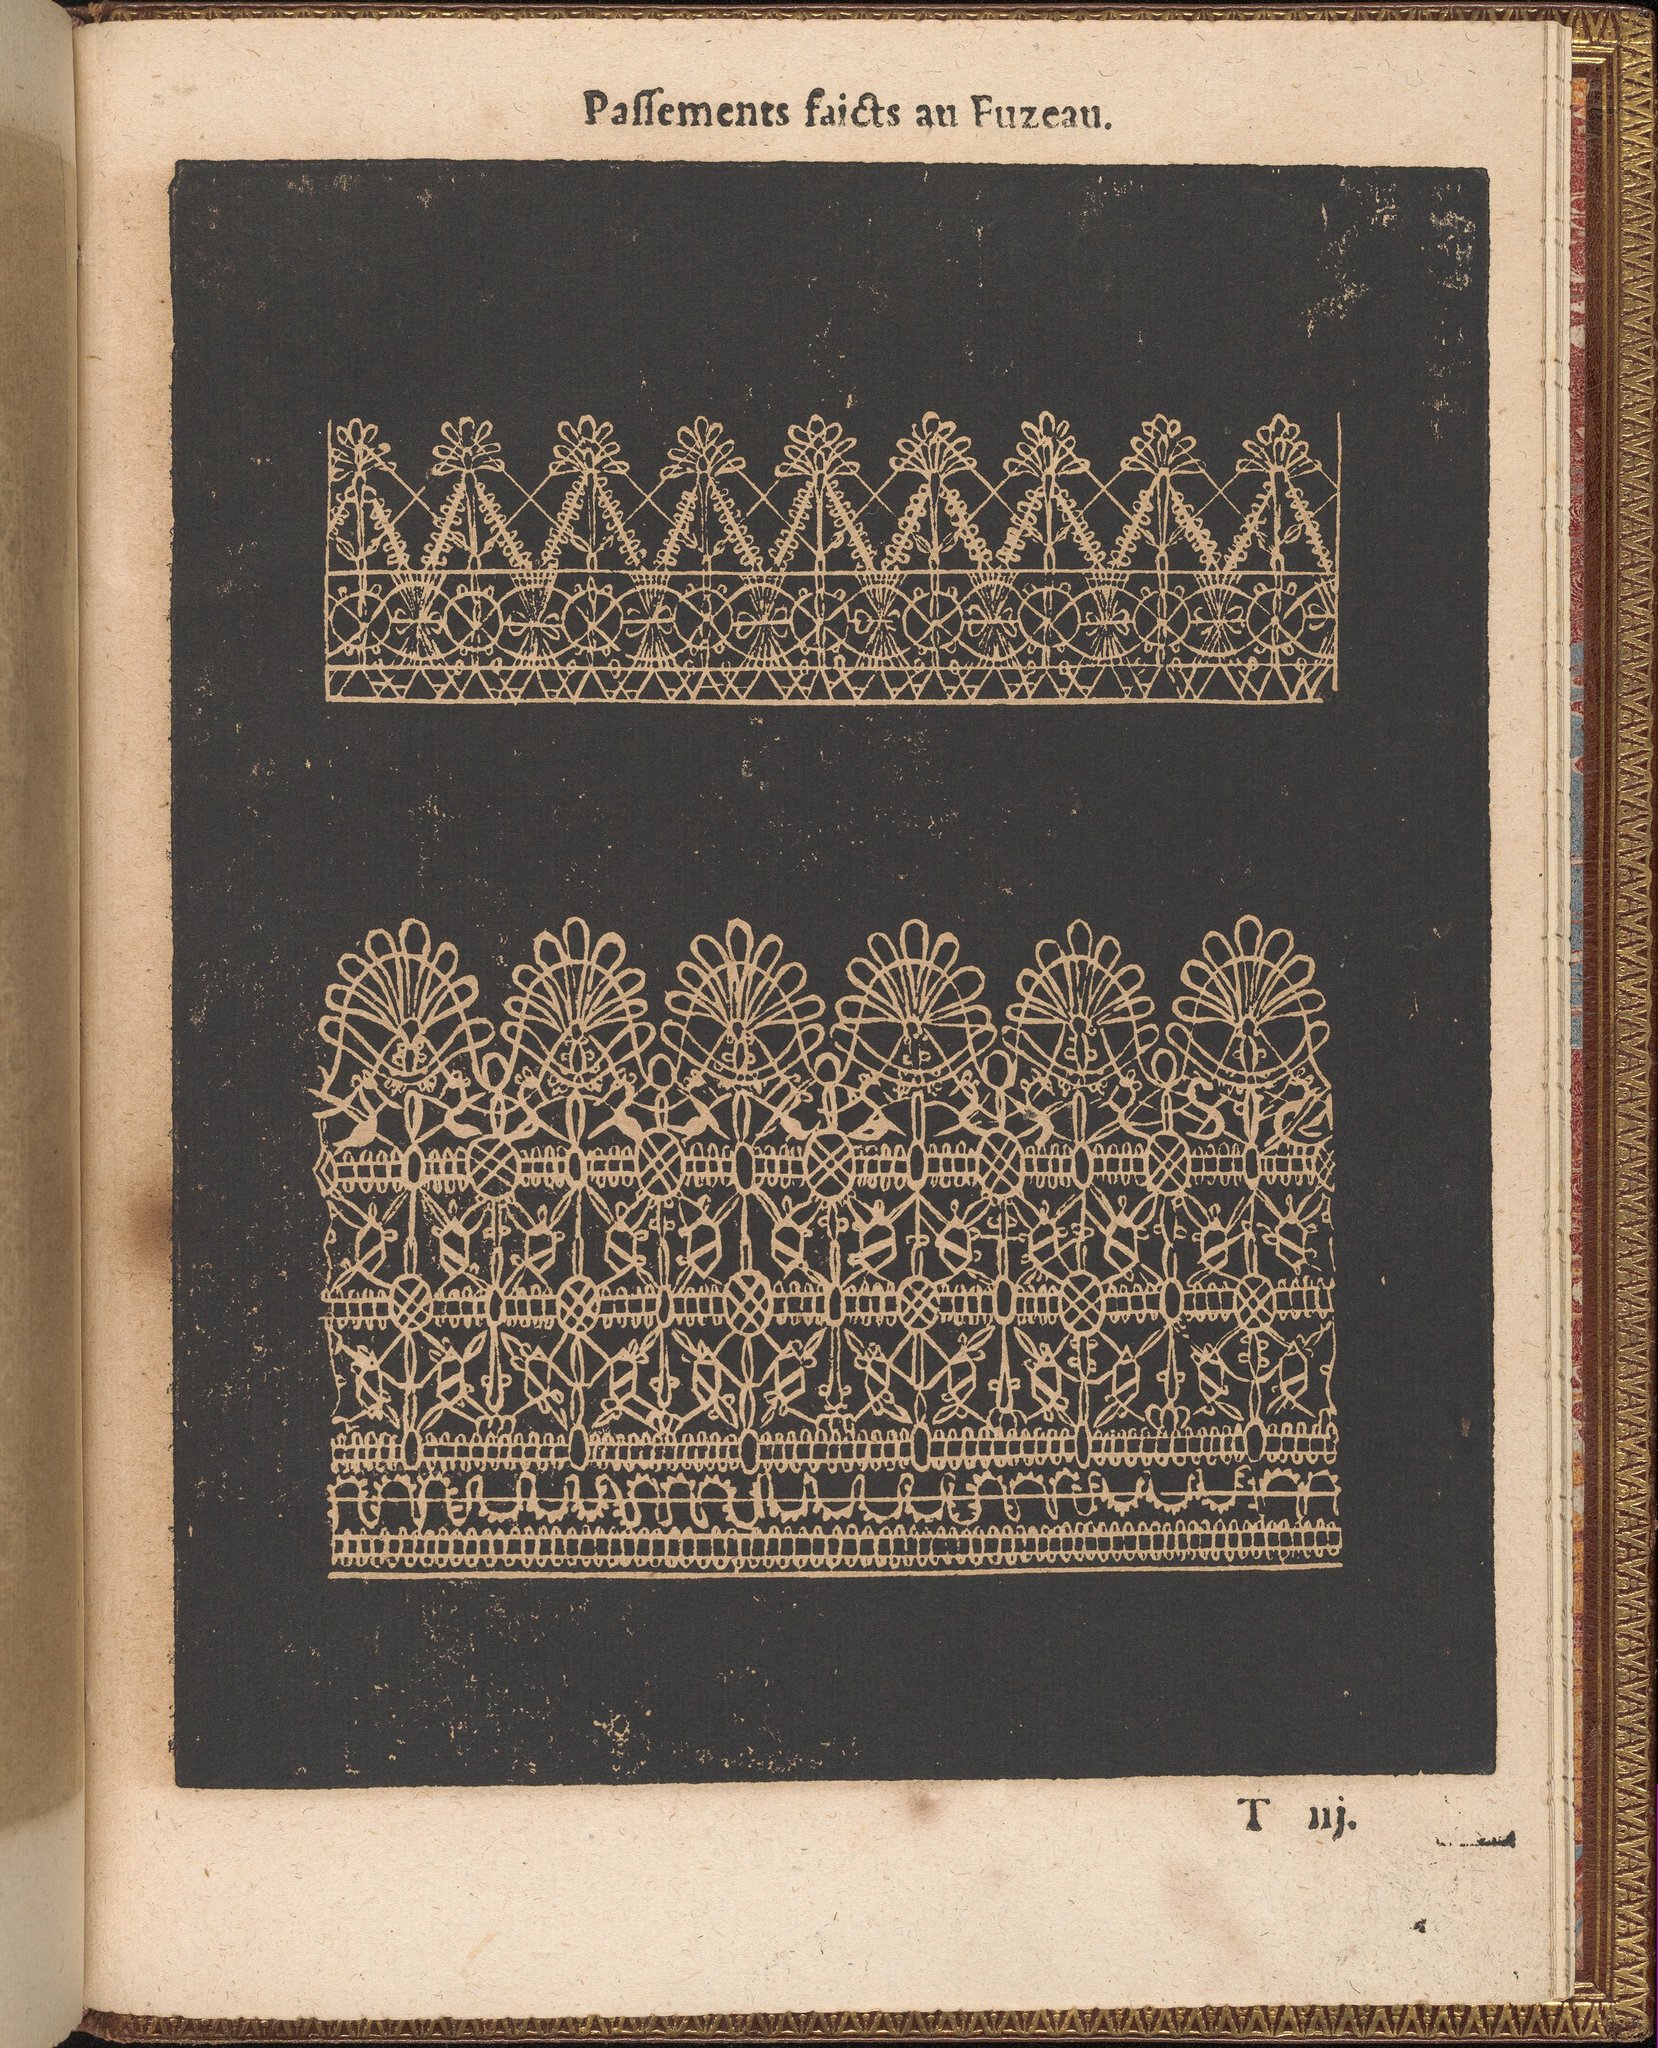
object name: book print ornament architecture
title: La Pratique de l'Aiguille, page 74 (recto)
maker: matthias mignerak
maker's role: author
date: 1605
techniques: woodcut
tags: ornament